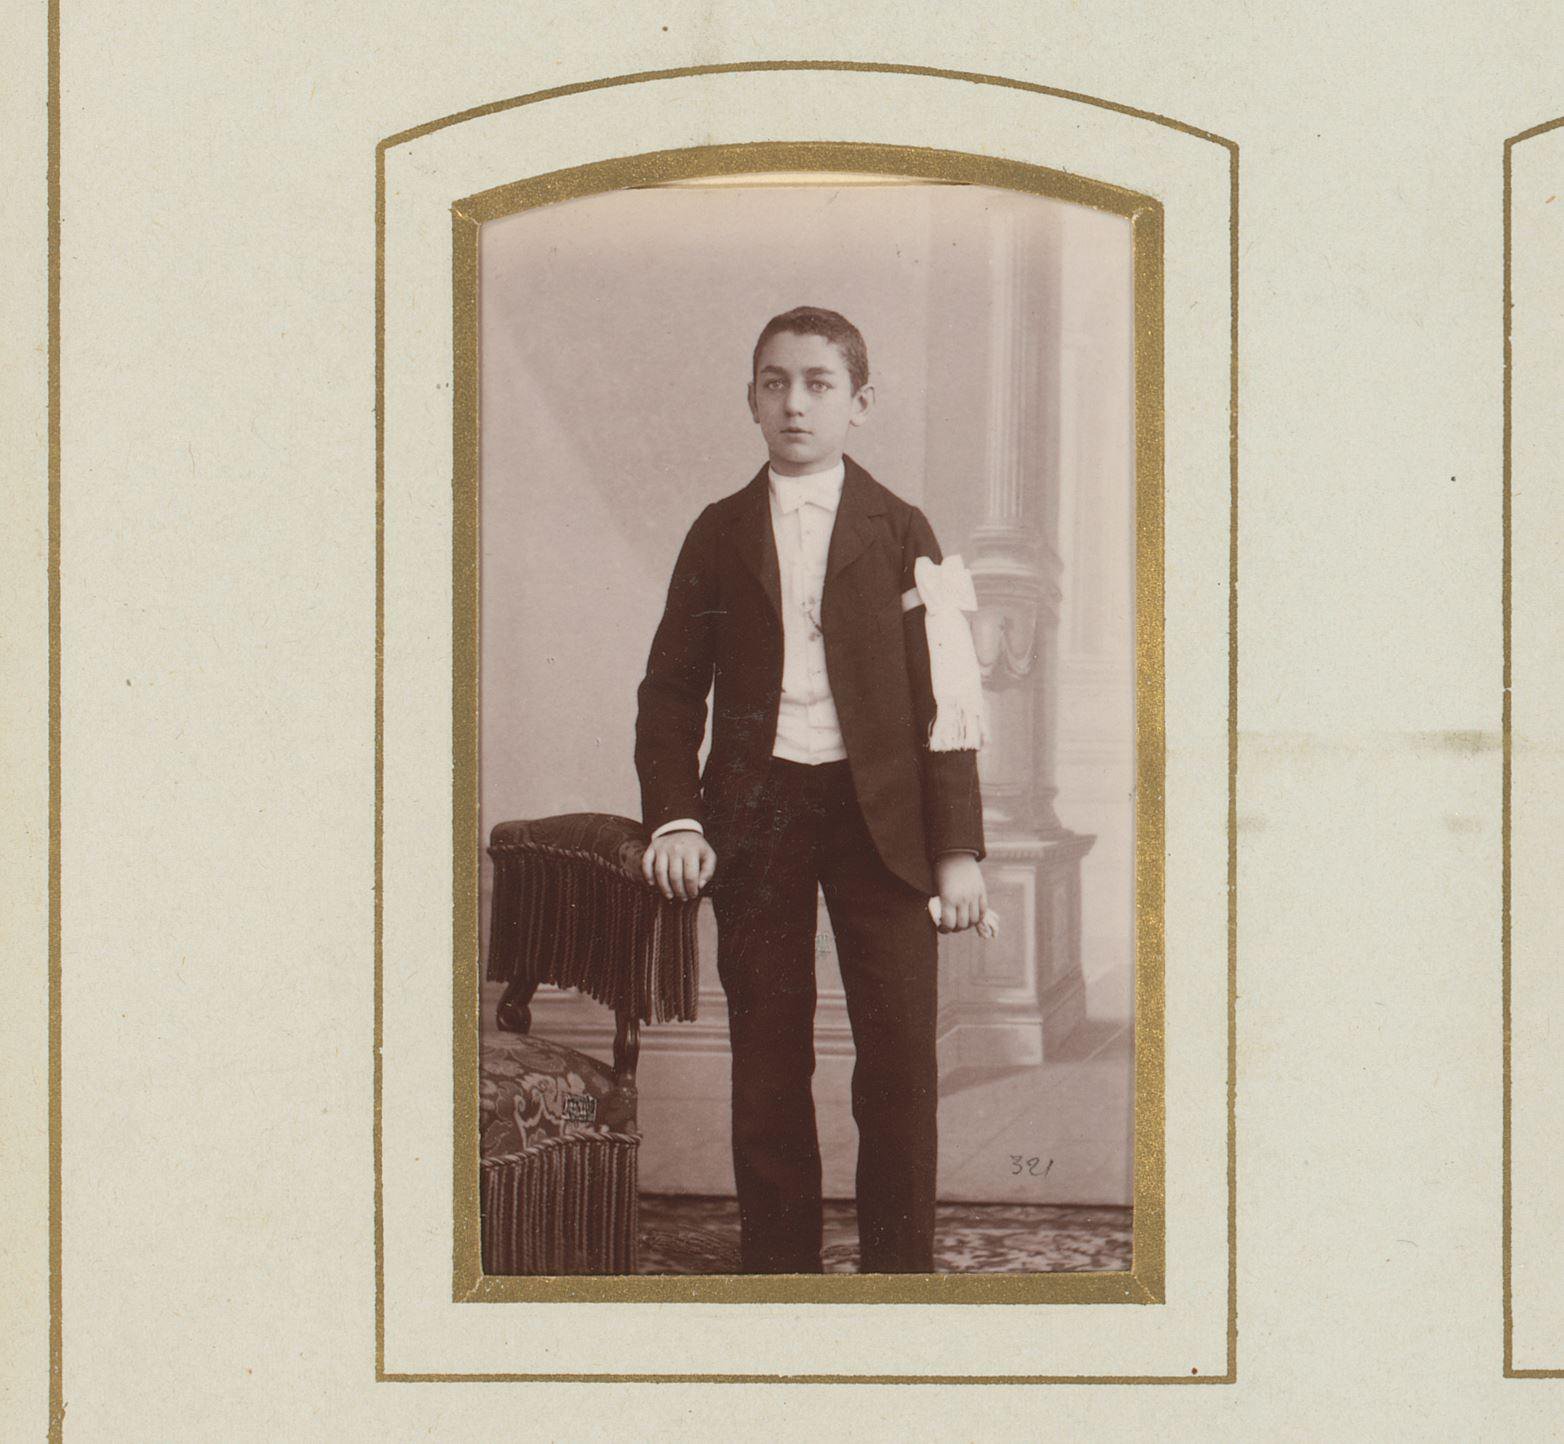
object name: photograph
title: Portret van een jongen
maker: anatole van den hove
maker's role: fotograaf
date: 1874-1900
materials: cardboard, photographic support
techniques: collodion silver print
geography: paris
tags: boy (child between toddler and youth), historical persons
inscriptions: number: ‘321’, inscription: ‘Anatole van den Hove/ 36 Boulevard de la Villette/ AU REZ-DE-CHAUSSÉE/ Paris’